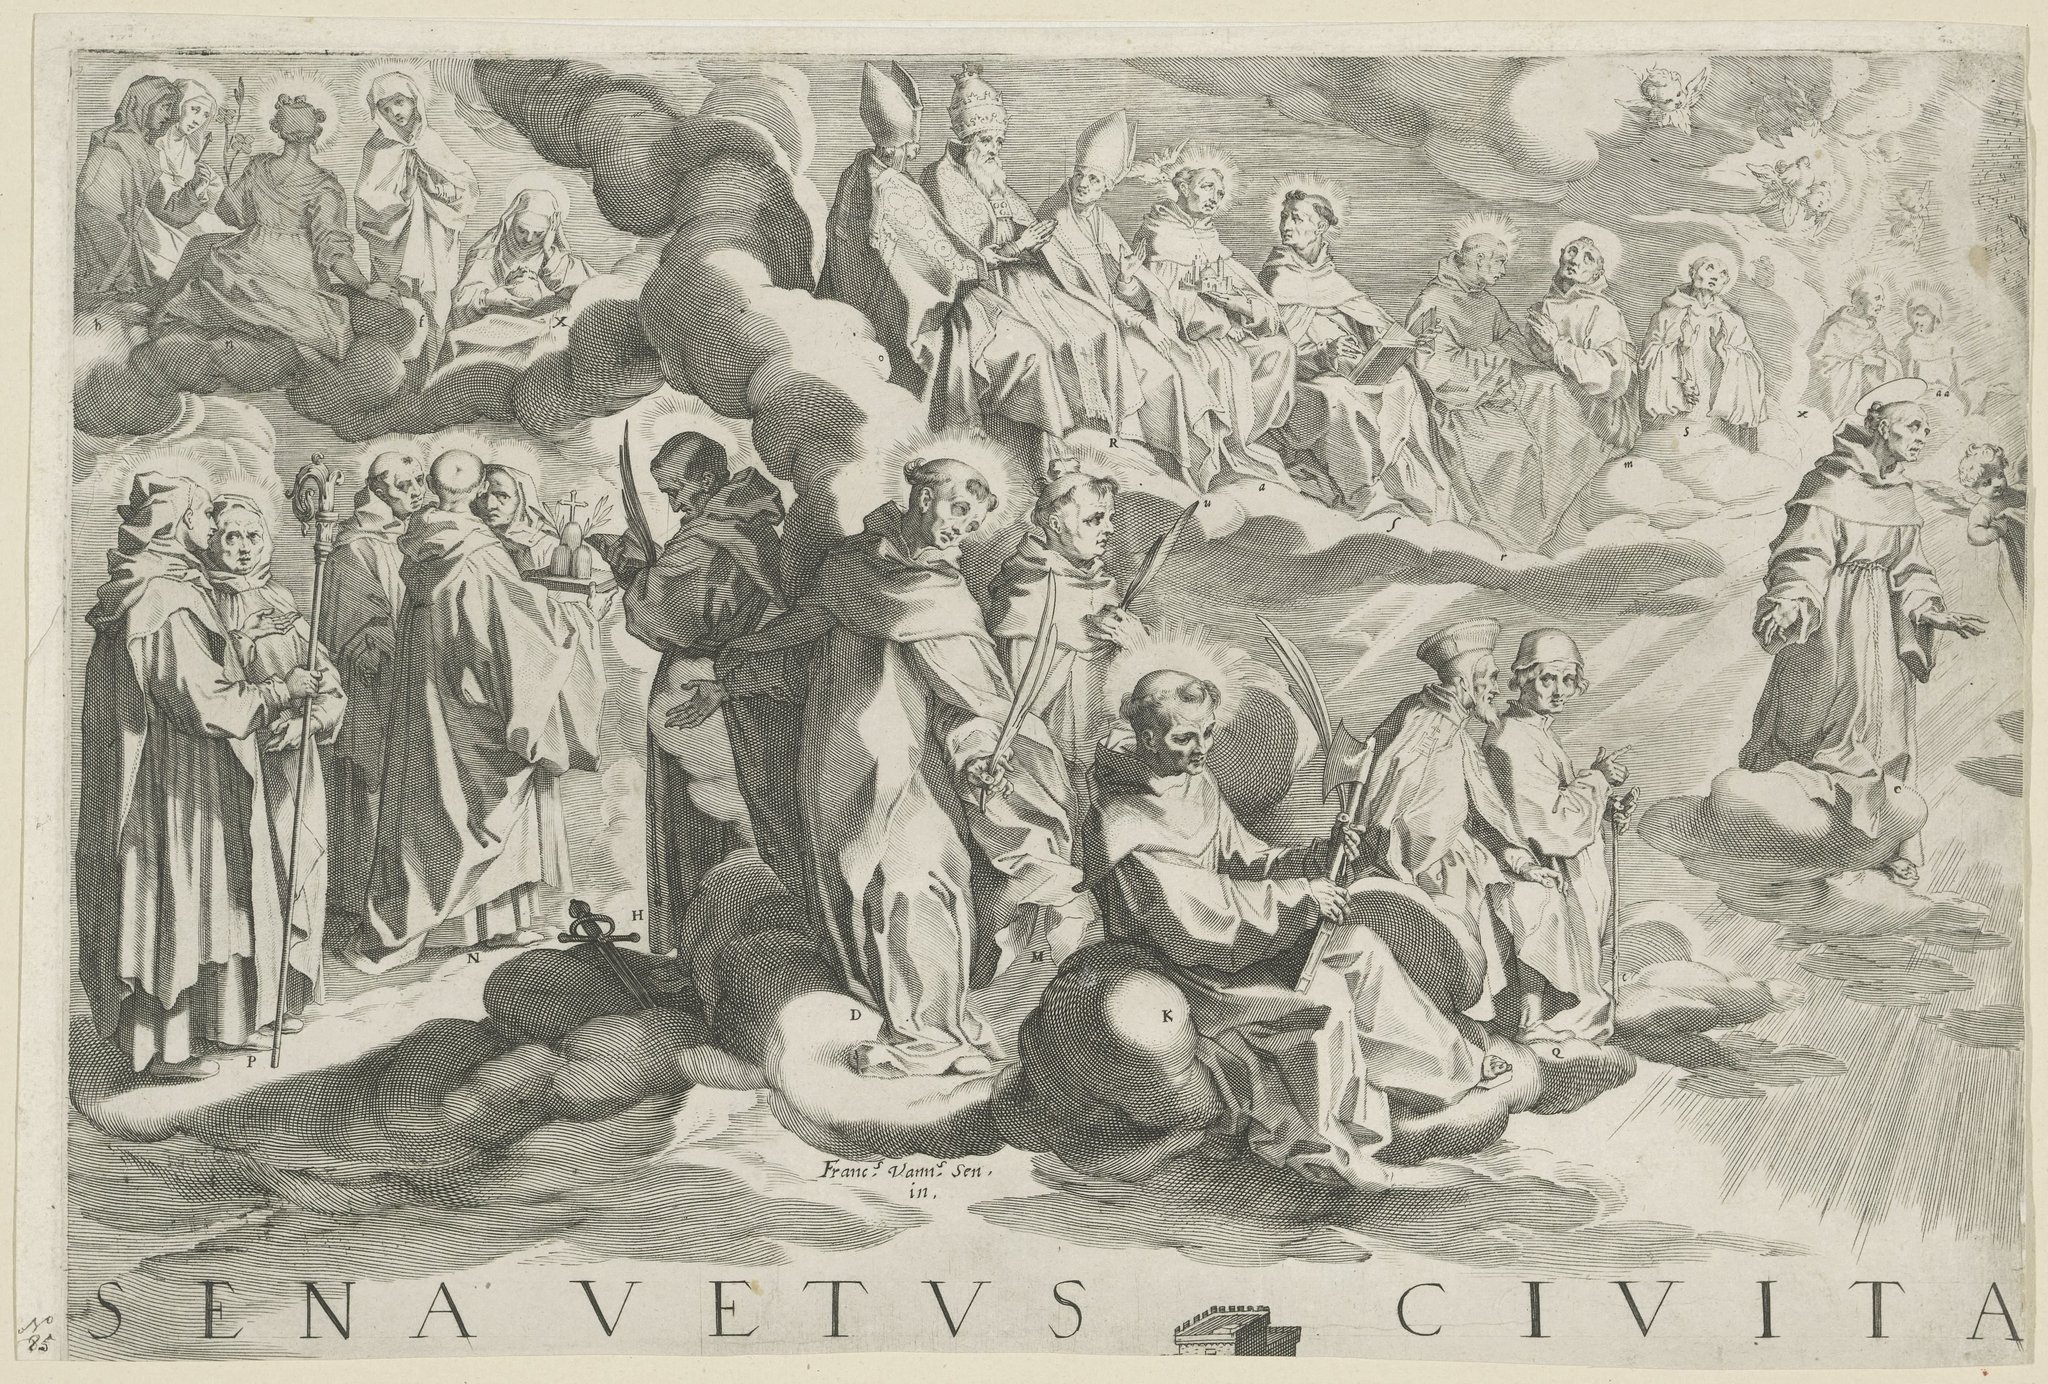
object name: print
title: Senavetus civitas virginis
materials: paper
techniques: engraving, etching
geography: tuscany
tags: coat of arms (as symbol of the state, etc.), mary (without the christ-child), archbishop, bishop, etc. (roman catholic), city-view in general; 'veduta', maps, atlases, cardinal, saints, female saints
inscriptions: number: ‘No. 25’, collector's mark: Lugt 240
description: Deel van een plattegrond van Siena. Boven de stad heiligen, bisschoppen, kardinalen en Maria op wolken. Onderste helft van prent is afgesneden.